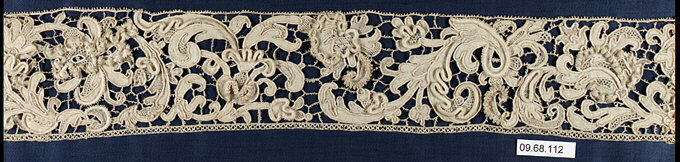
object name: border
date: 1634-1666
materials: lace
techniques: gros point, lace